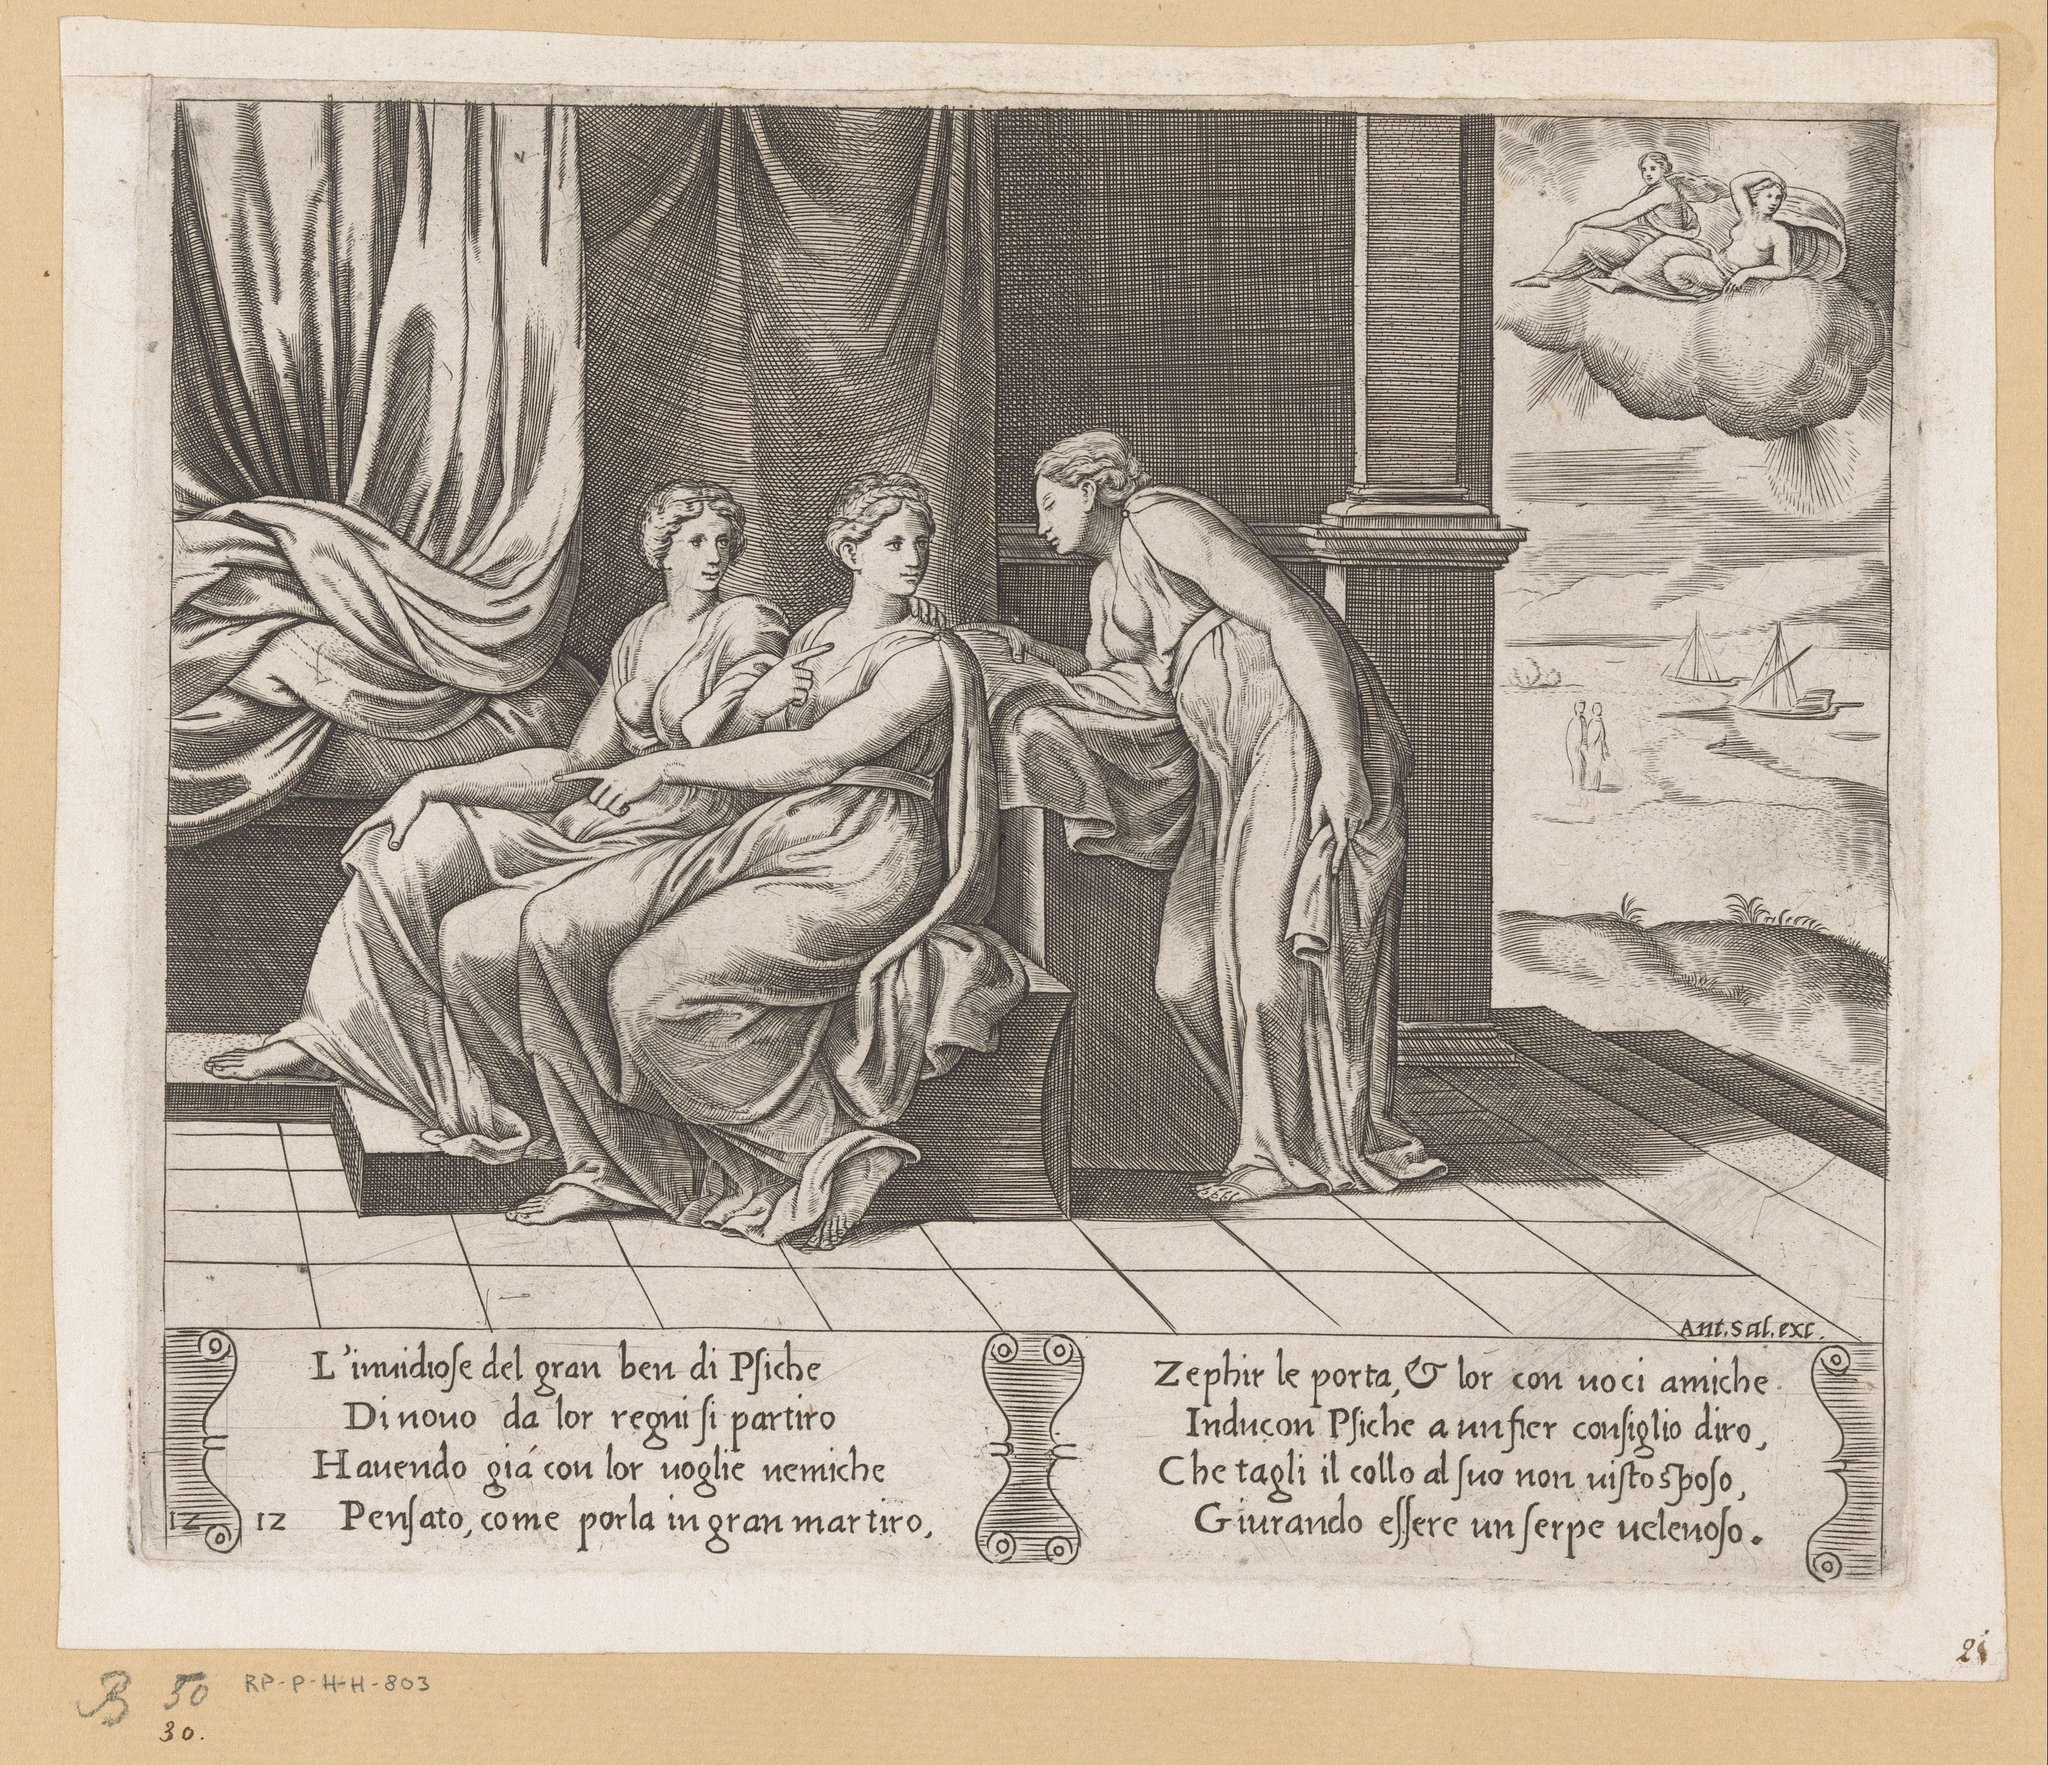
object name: print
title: Verhaal van Amor en Psyche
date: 1530-1560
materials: paper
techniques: engraving, intaglio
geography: rome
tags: psyche and her sisters in the palace, psyche's sisters are brought to her by zephyrus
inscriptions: collector's mark: Lugt 11, collector's mark: Lugt 10, number: ‘24’, collector's mark: ‘Hinloopen’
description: Psyche wordt er door haar twee zusters van overtuigd dat zij niet met Amor heeft geslapen maar met een giftige slang. Rechtsboven de twee zusters die naar Psyche worden gebracht door Zephyrus (de personificatie van de westenwind). Italiaanse tekst in twee cartouches in ondermarge. Tweemaal genummerd linksonder: 12.